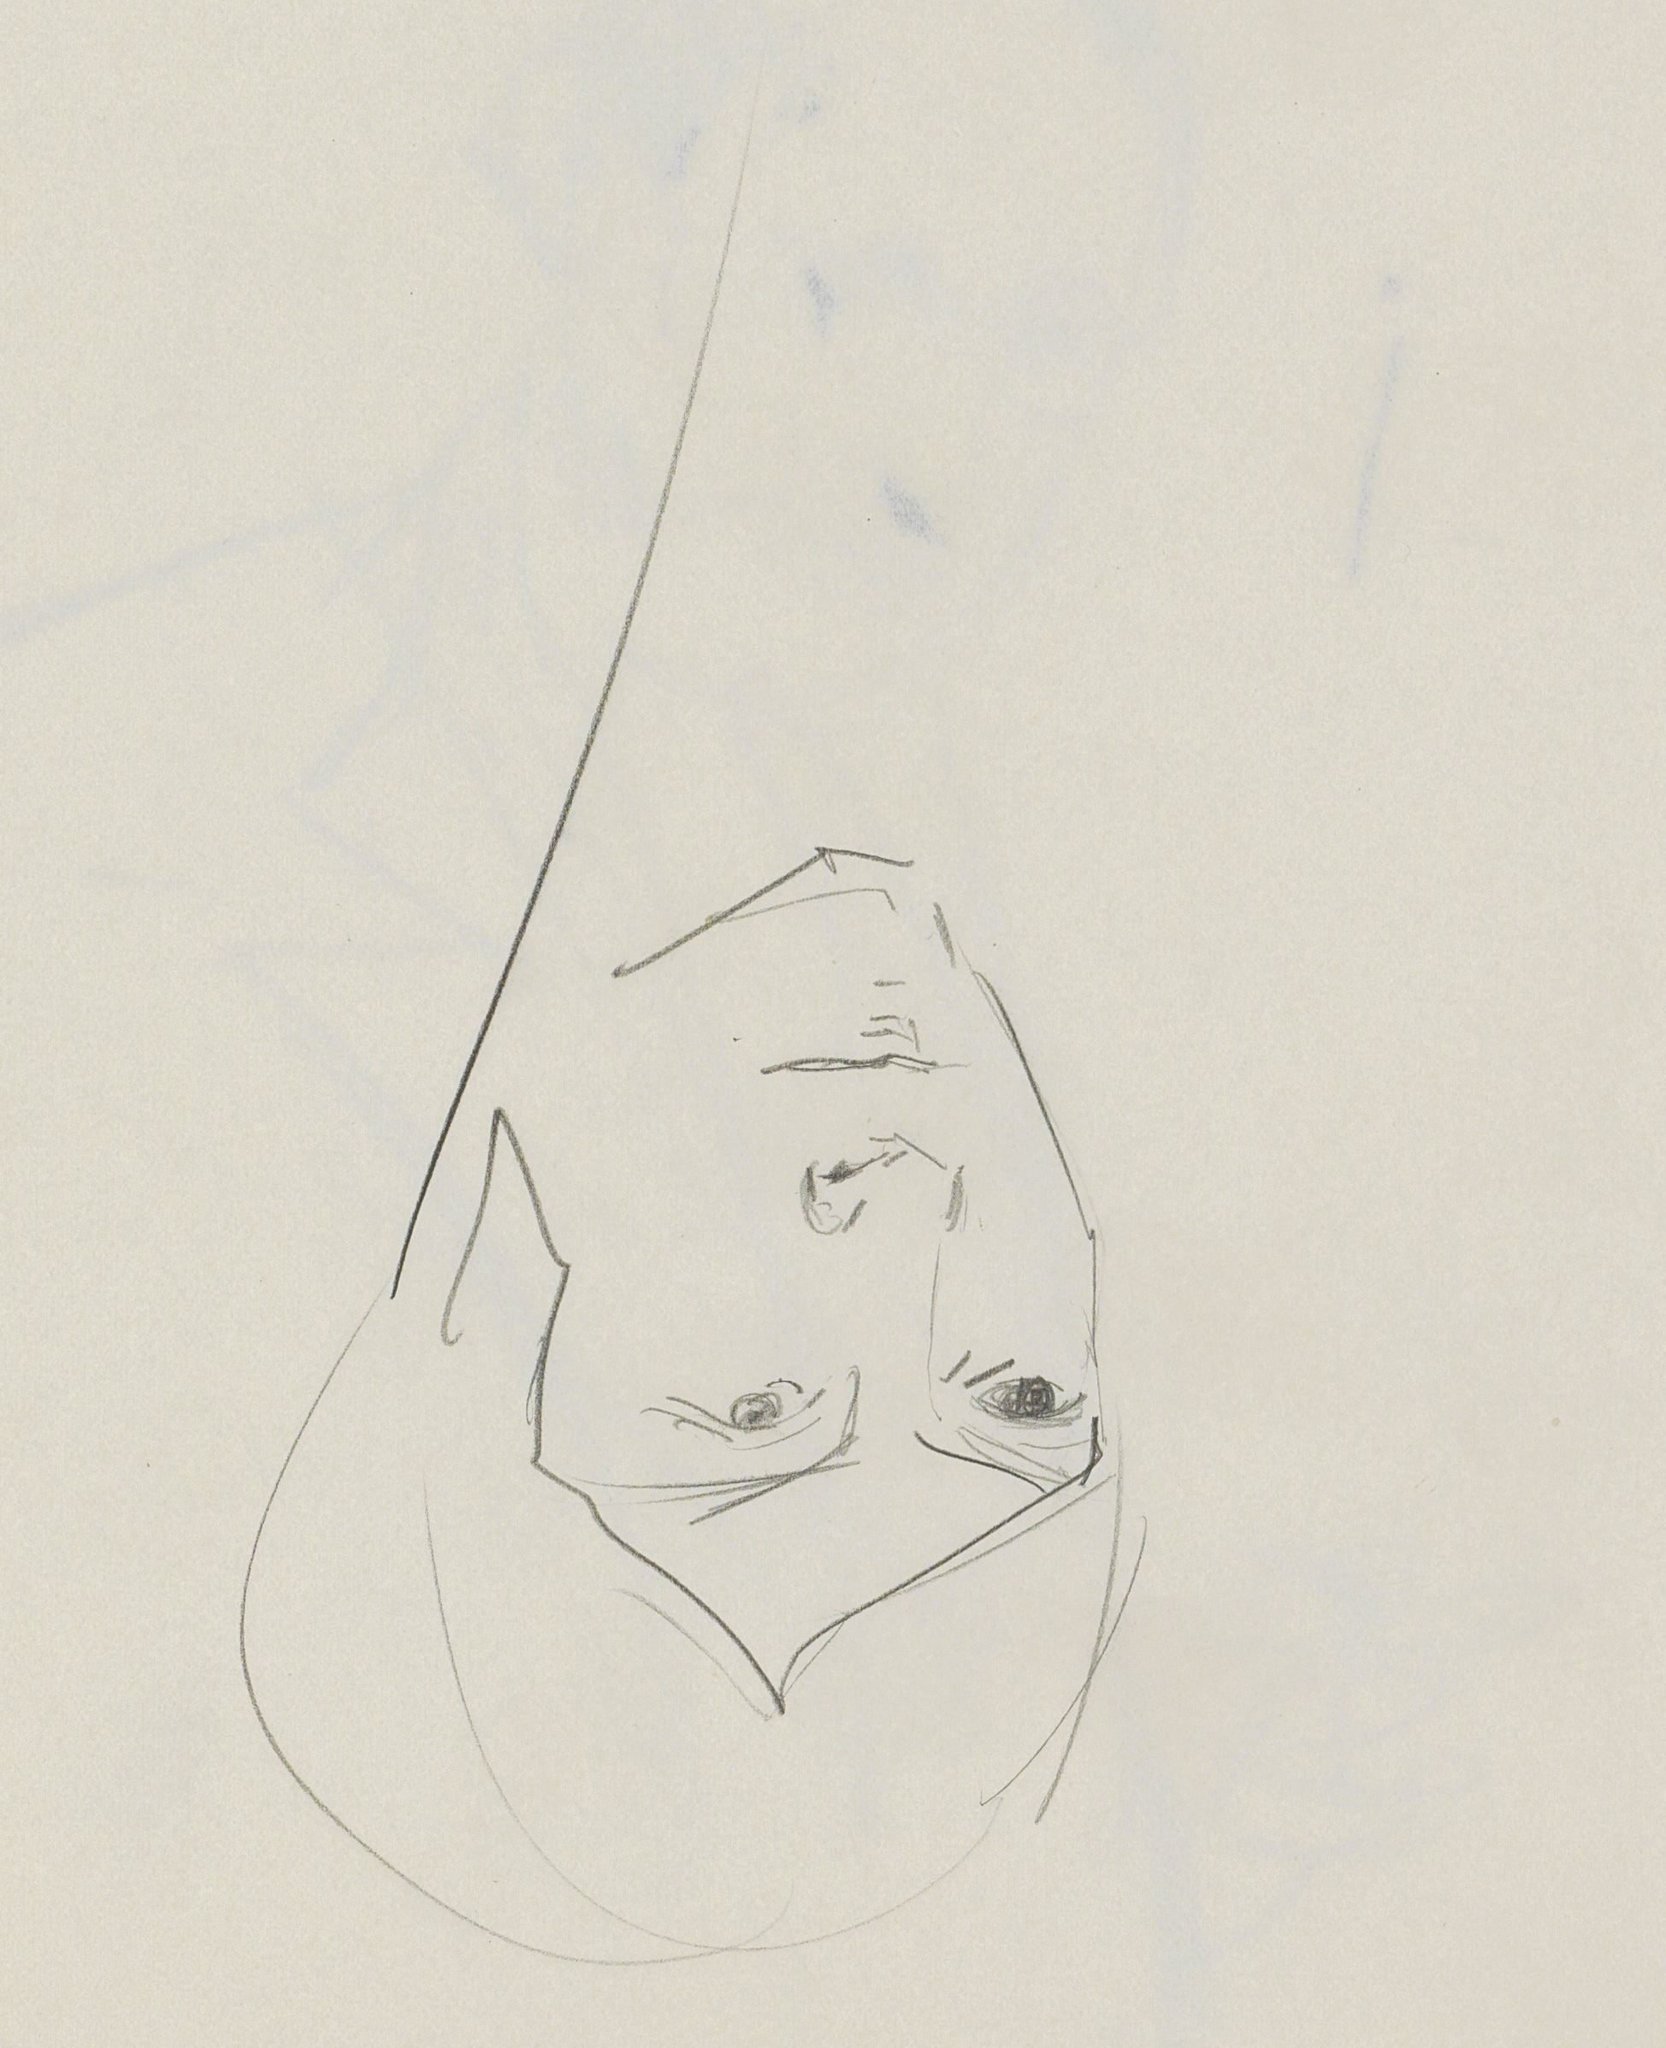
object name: sketchbook leaf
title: Hoofd, mogelijk Japans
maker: isaac israels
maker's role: draughtsman, painter, print maker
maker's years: 1865-1934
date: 1925-1934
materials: paper, pencil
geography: the hague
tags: head (human), japanese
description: Blad 20 verso uit schetsboek XXVI met 35 bladen.